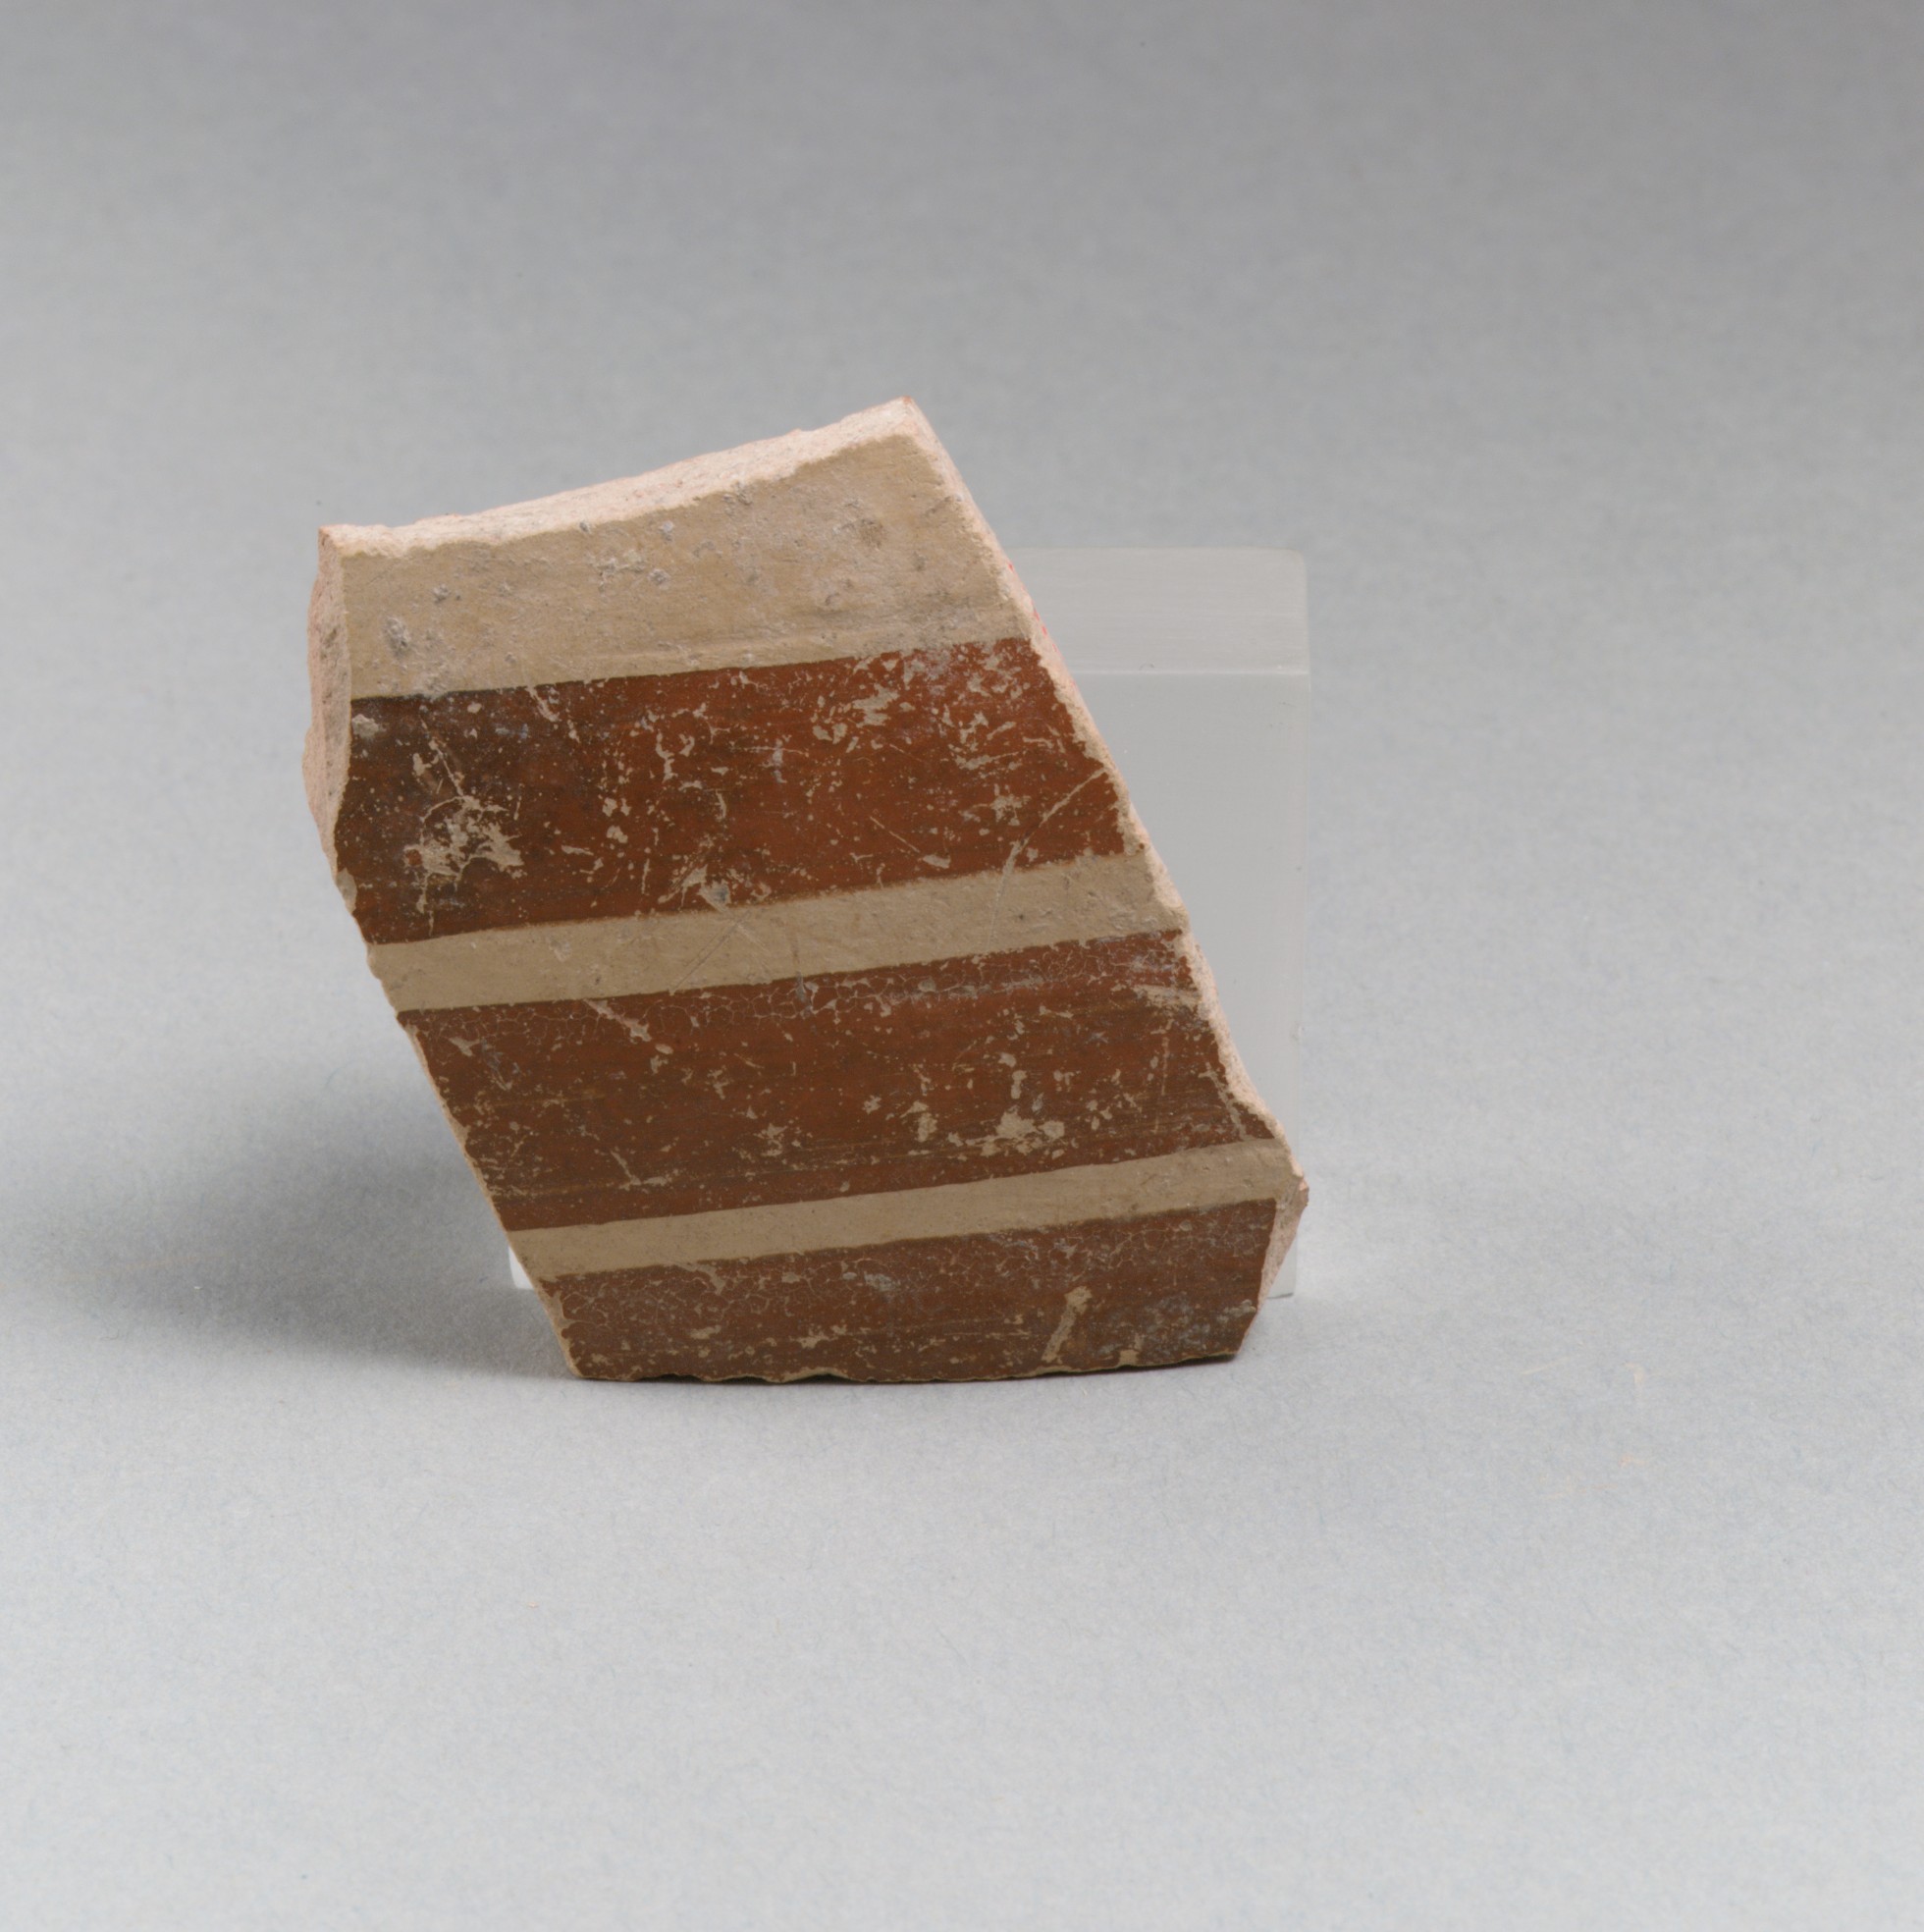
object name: vase fragment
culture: mycenaean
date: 1400-1300 BCE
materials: terracotta